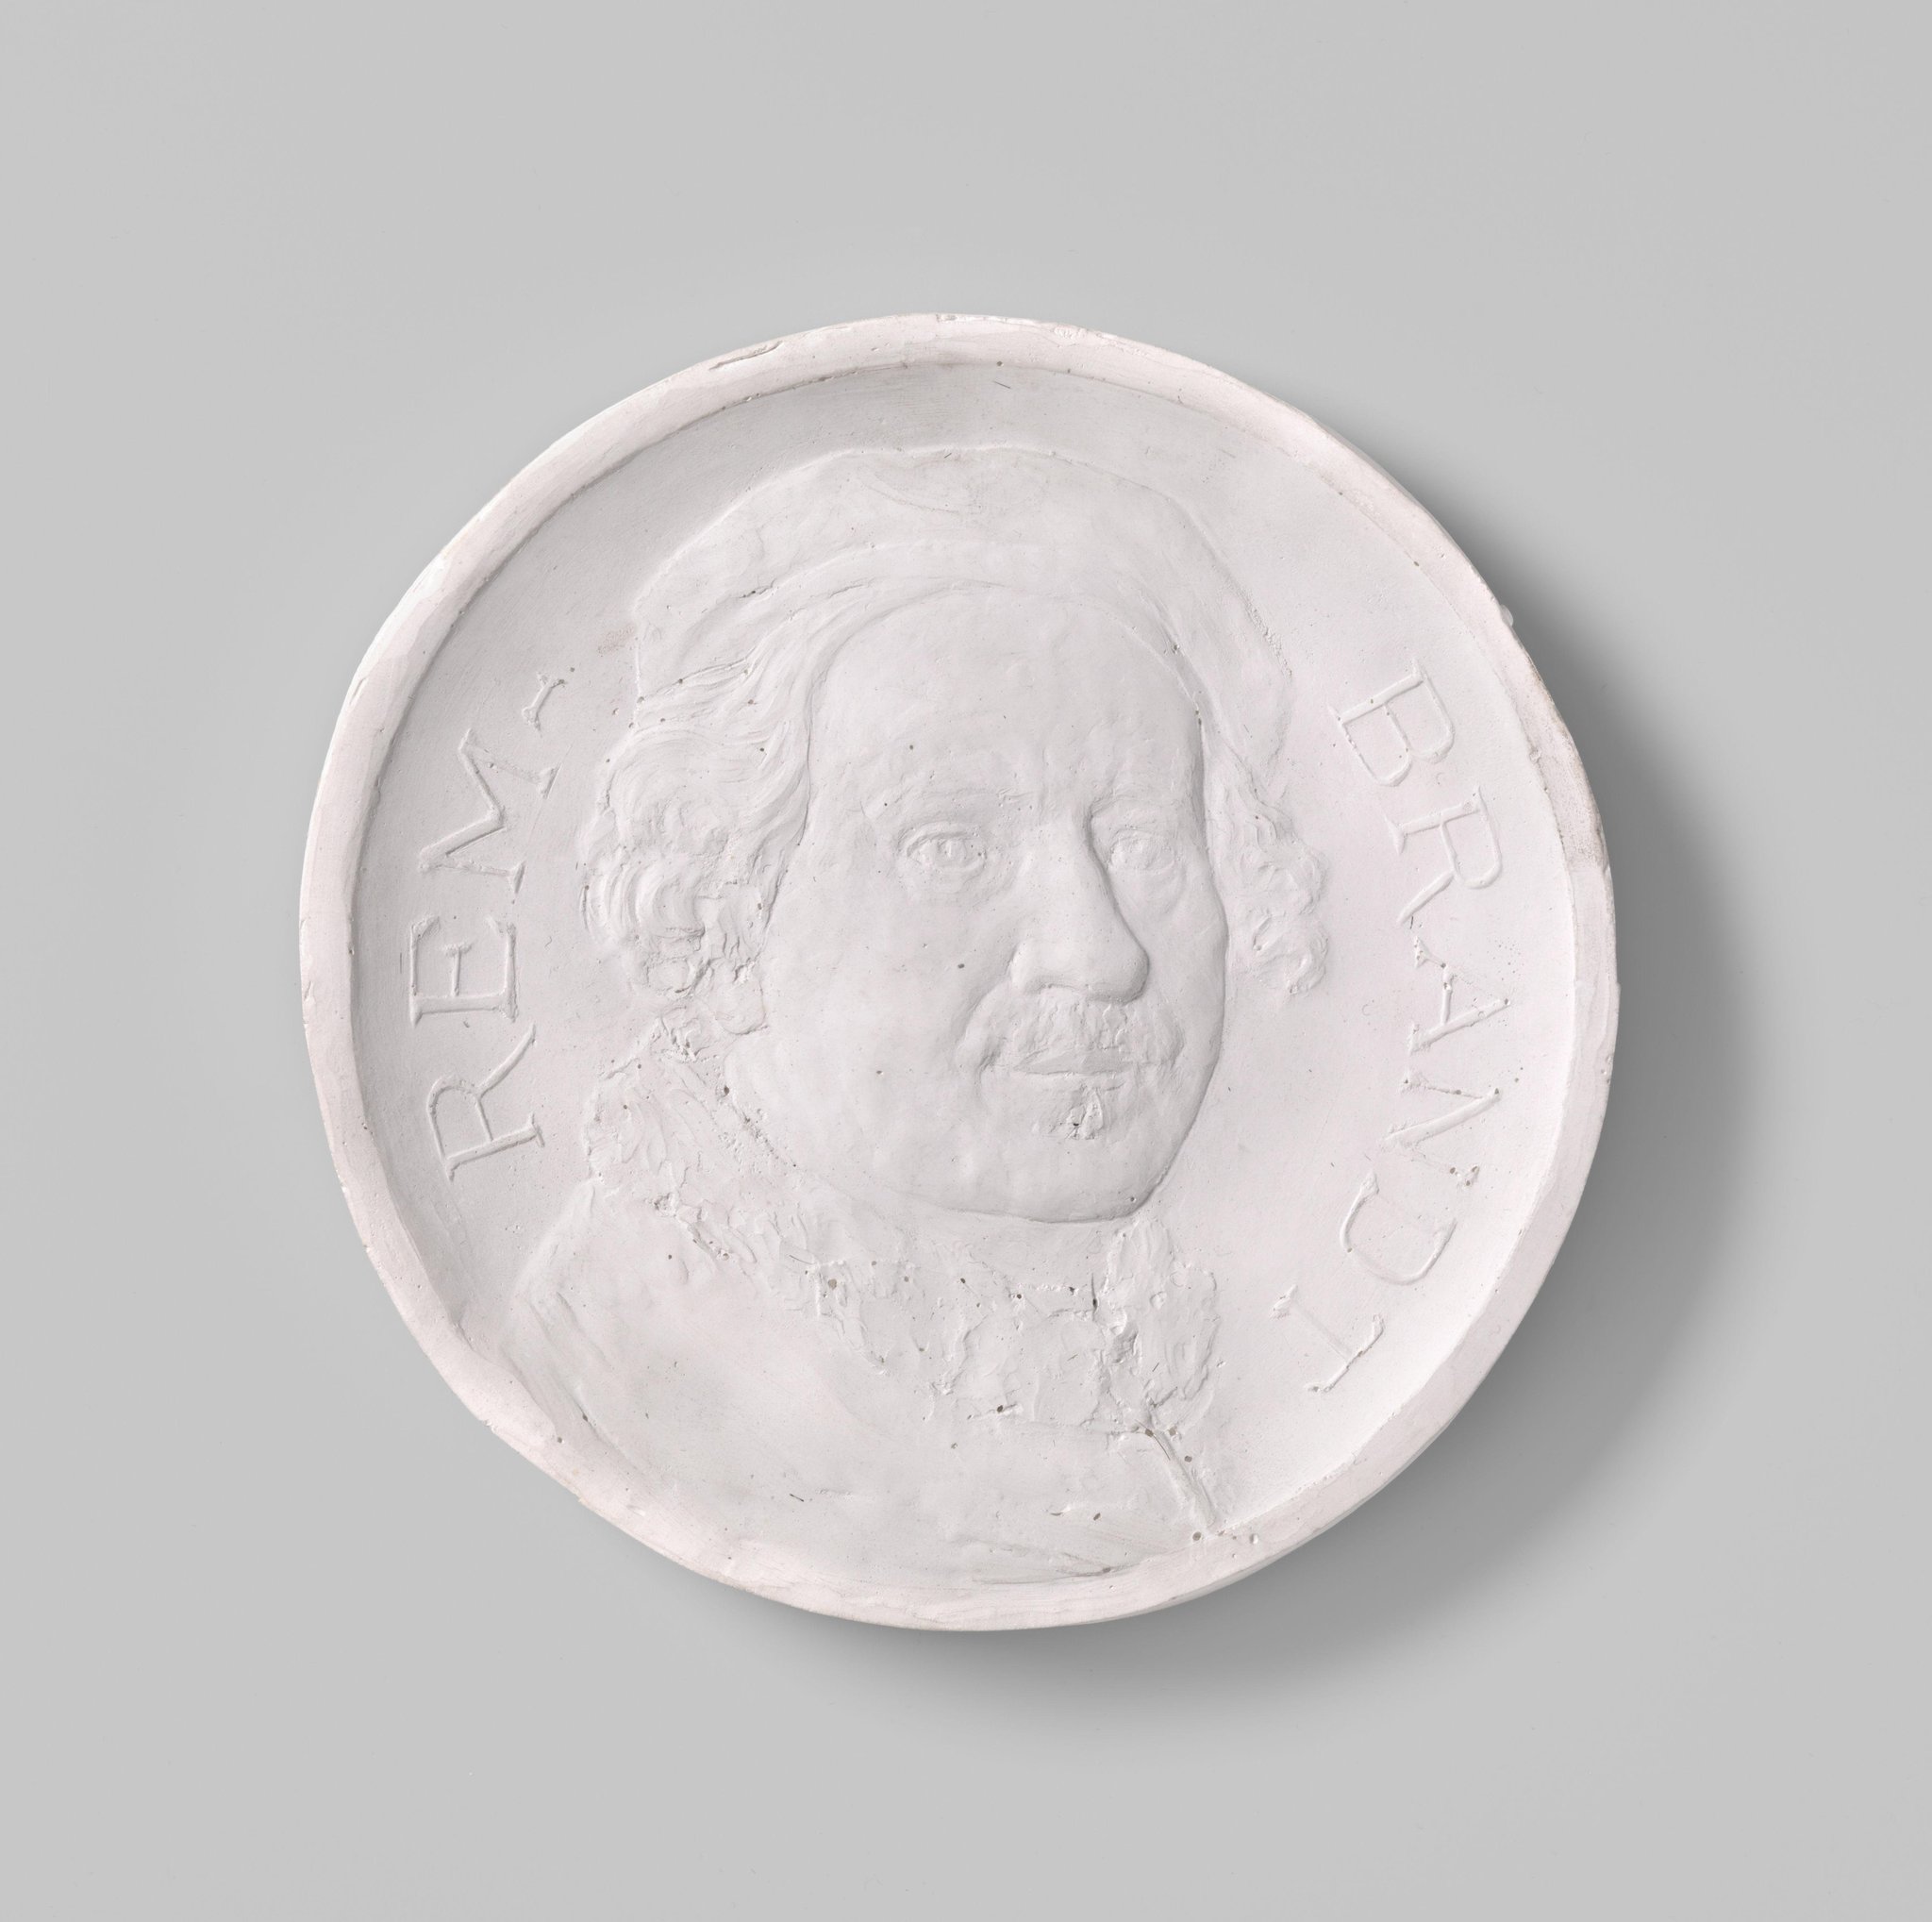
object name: preparatory study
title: Voorstudie in gips voor Rembrandt-penning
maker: johan melchior faddegon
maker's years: 1871-1941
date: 1906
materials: gypsum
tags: leiden, amsterdam, painter, print maker, draughtsman, rembrandt van rijn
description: Voorstudie in gips voor Rembrandt-penning.